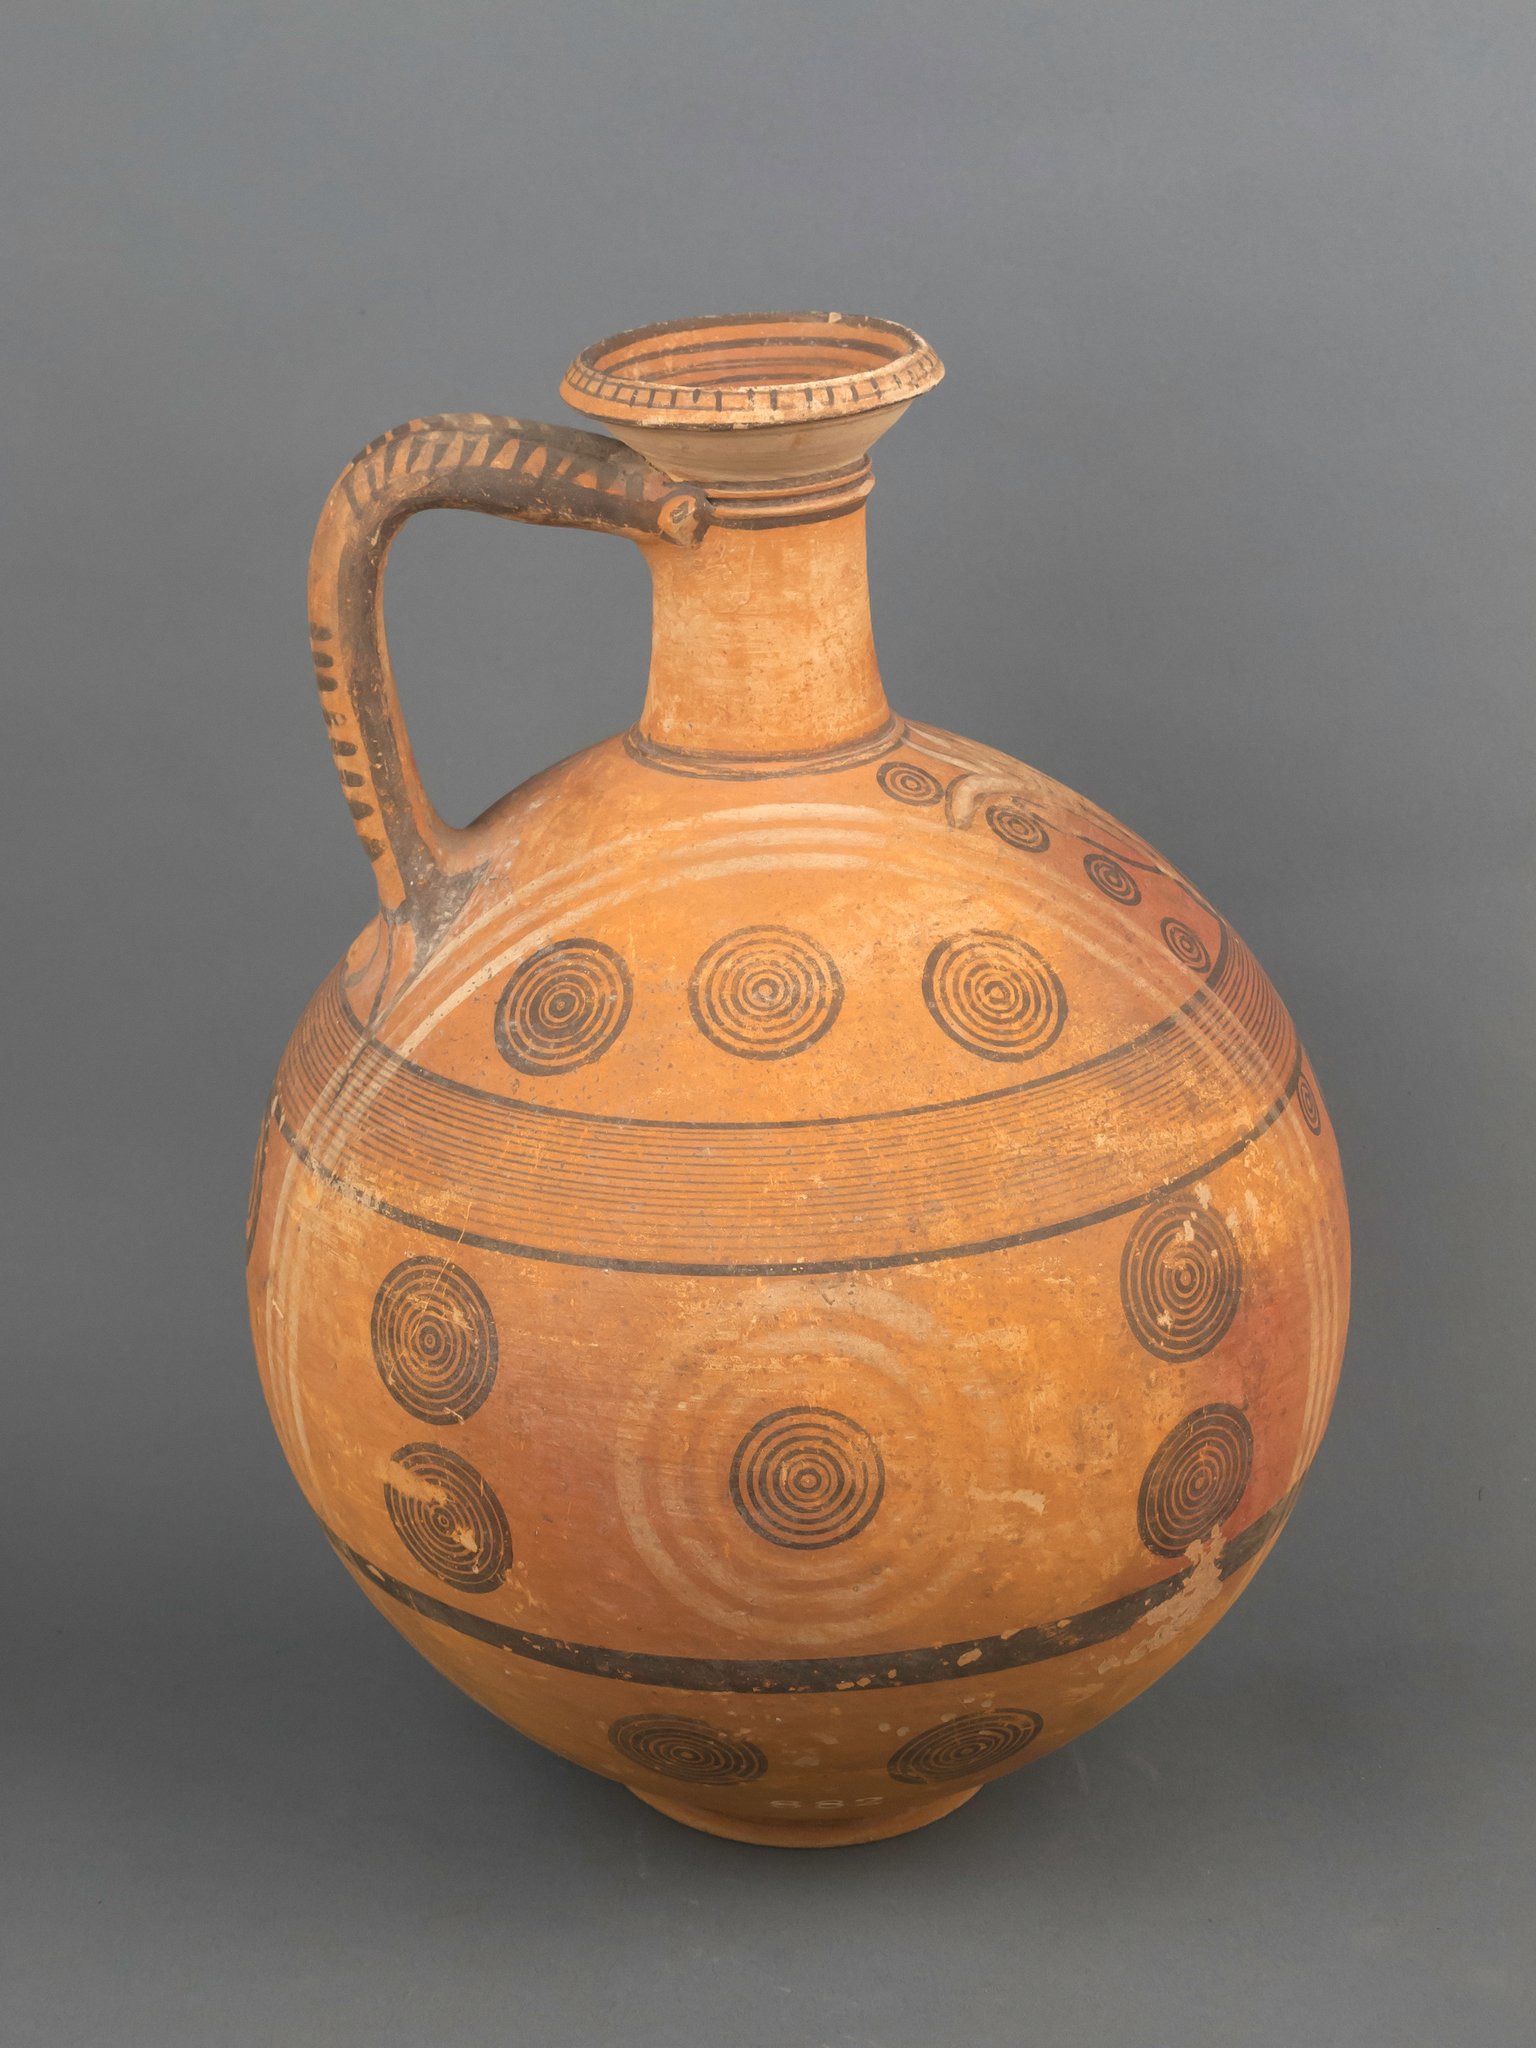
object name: jug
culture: cypriot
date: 750-480 BCE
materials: terracotta